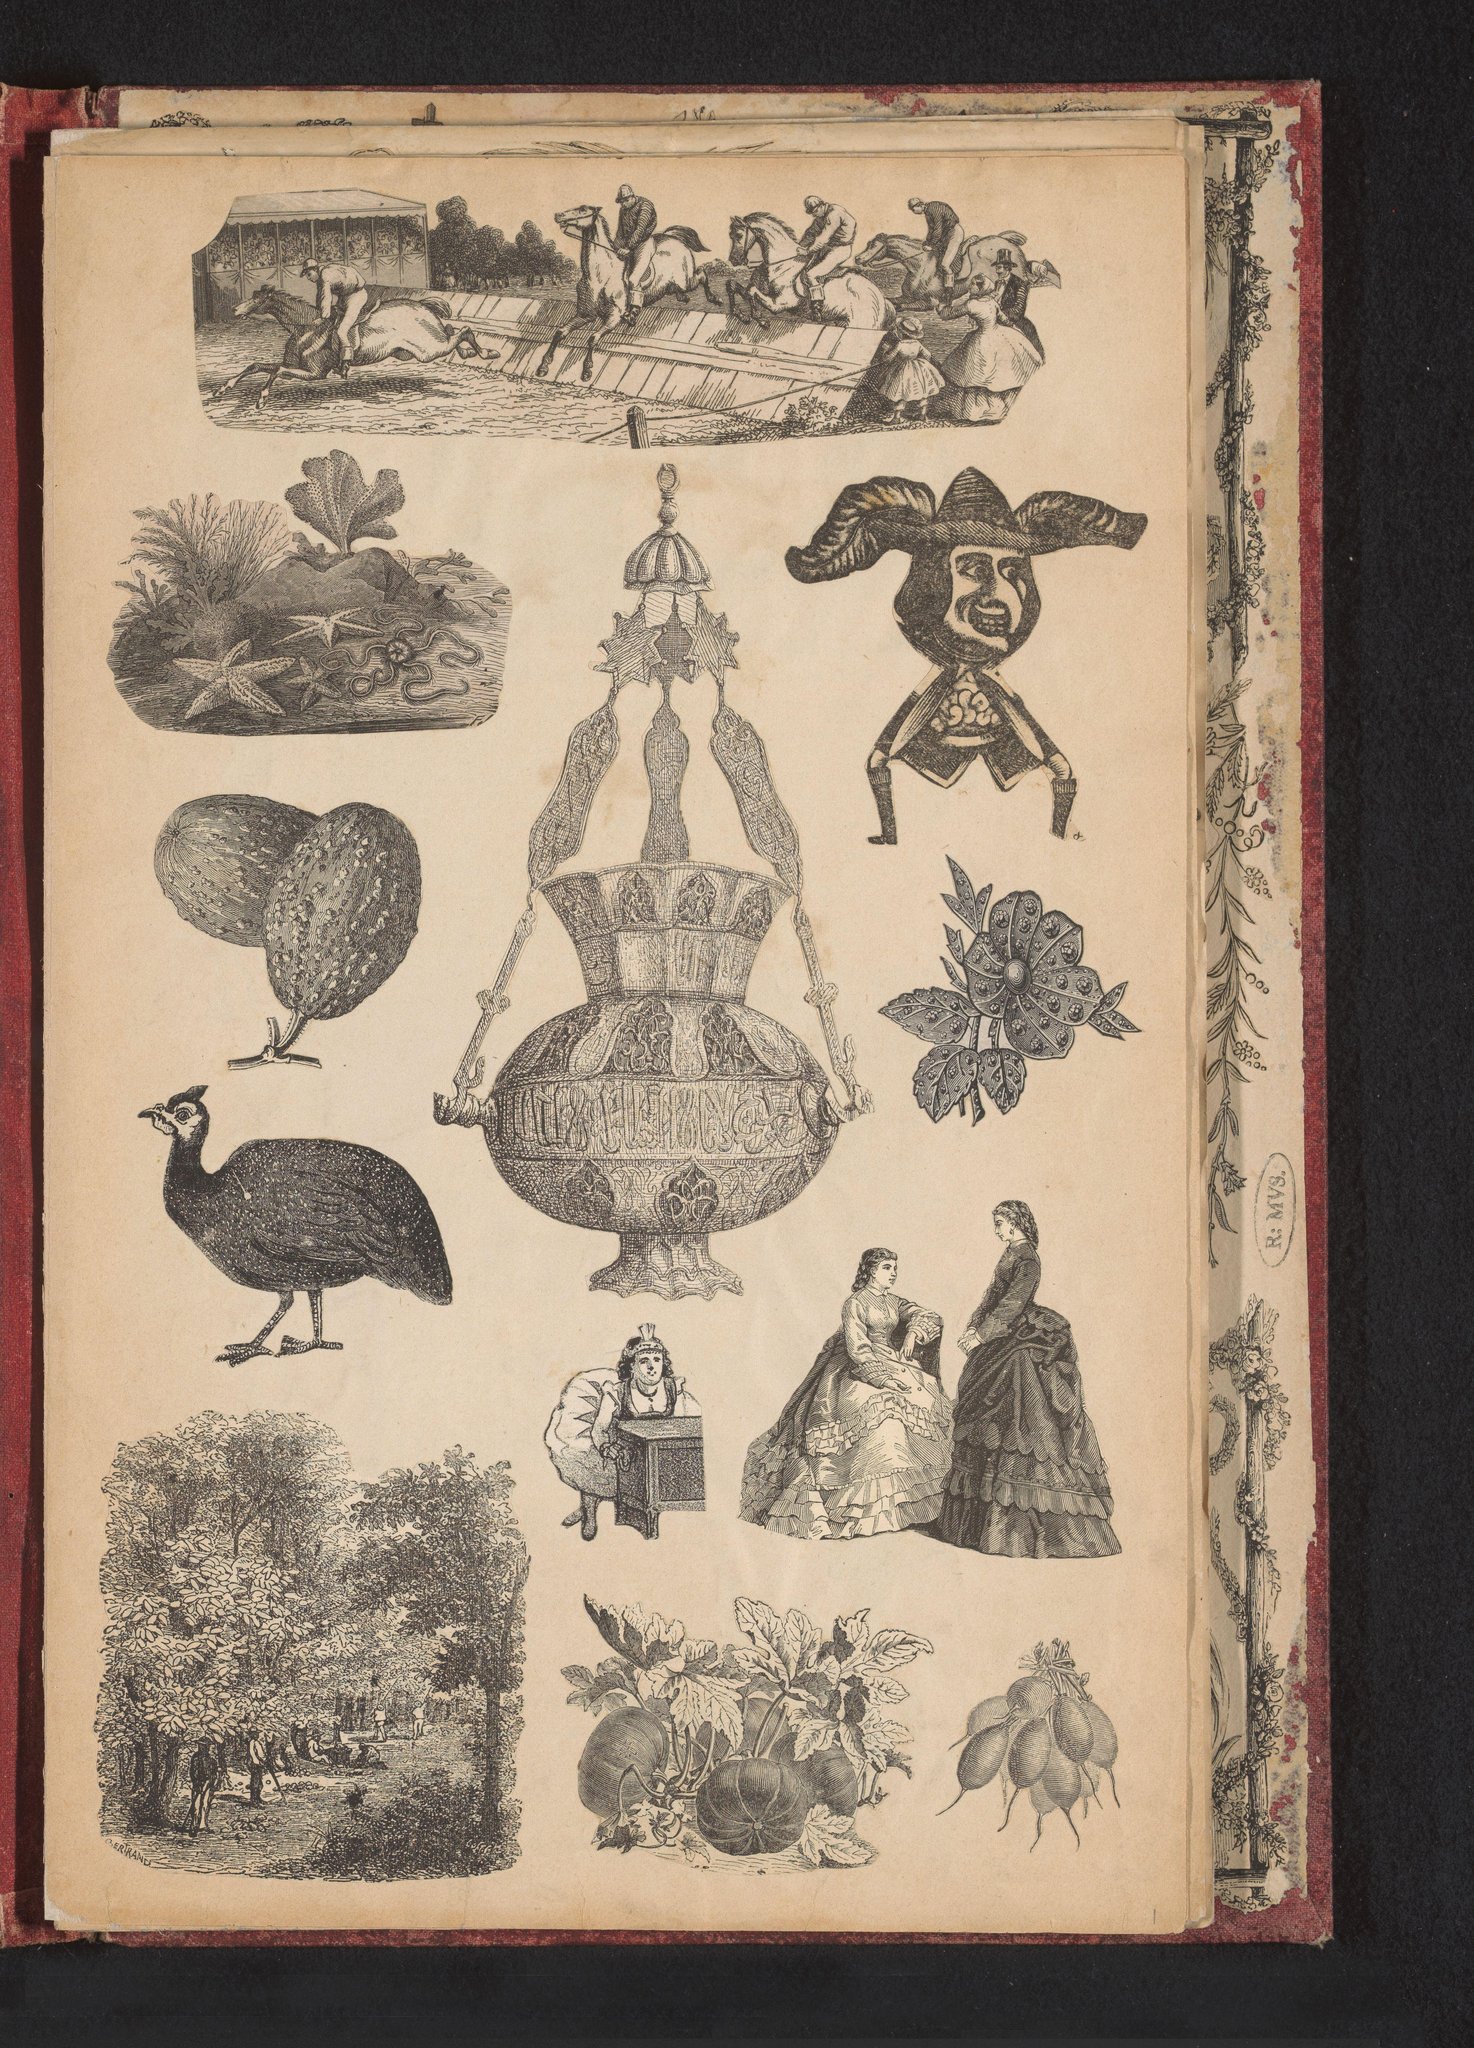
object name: collage visual work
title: Collage van uitgeknipte prenten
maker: Anonymous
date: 1870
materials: paper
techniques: engraving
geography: paris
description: Collage van uitgeknipte prenten. Onderdeel van een album met 32 bladen, aan beide zijden beplakt met uitgeknipte prenten, vermoedelijk afkomstig uit 19e-eeuwse tijdschiften.